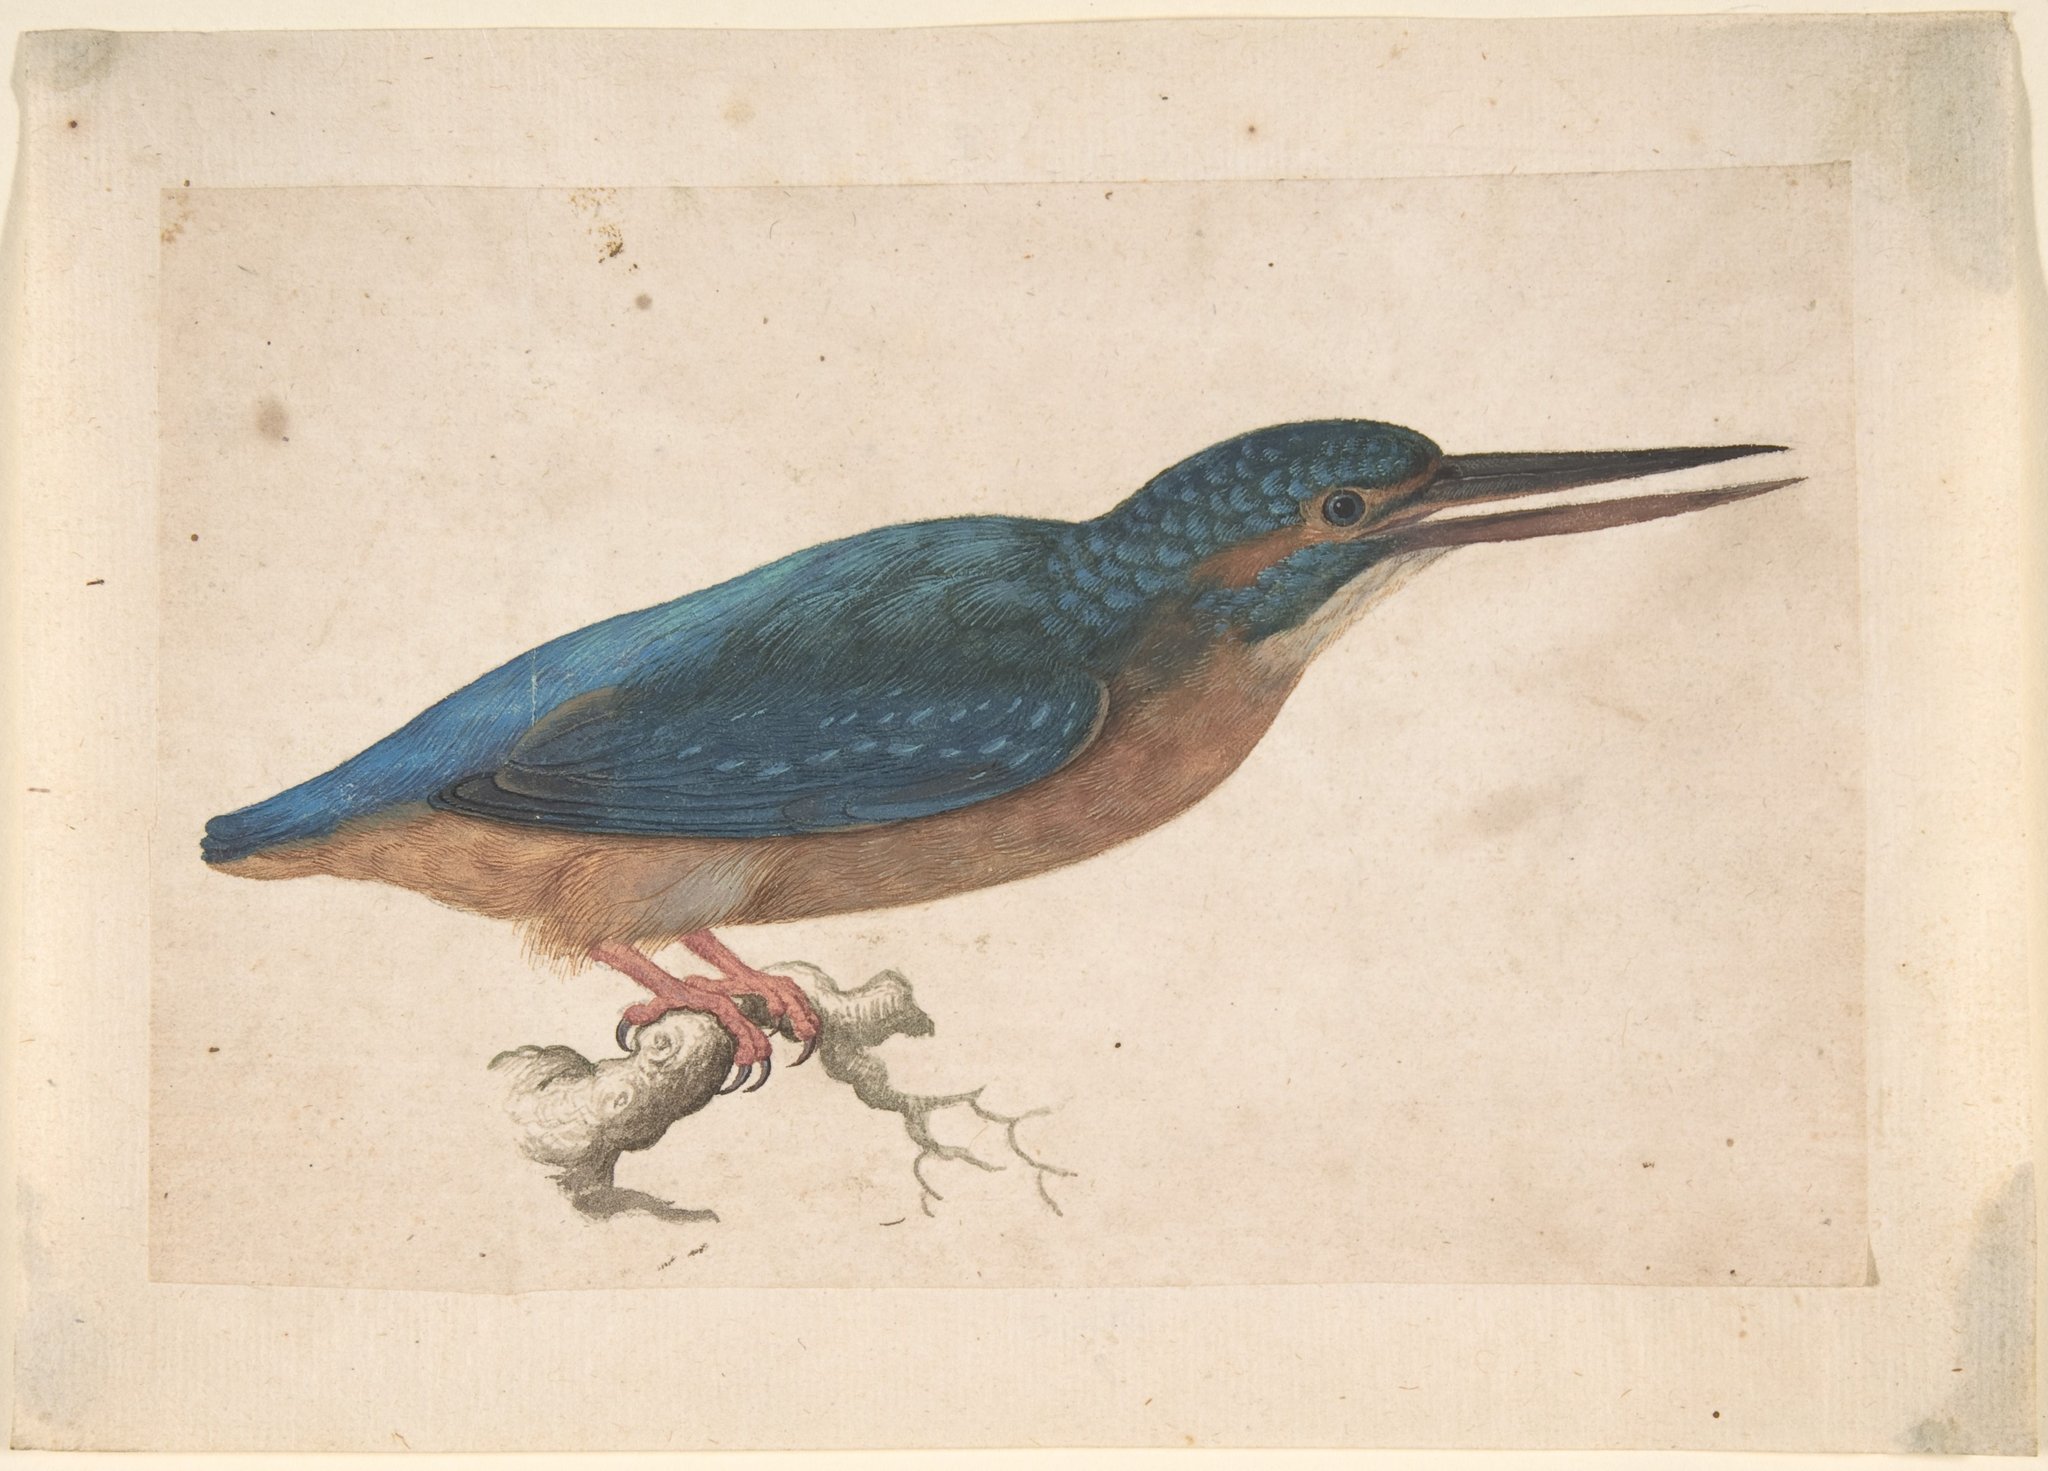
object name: drawing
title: A Kingfisher on a Branch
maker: jacques le moyne de morgues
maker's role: artist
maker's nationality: french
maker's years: 1533-1588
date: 1501-1600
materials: chalk, gouache, watercolor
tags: birds